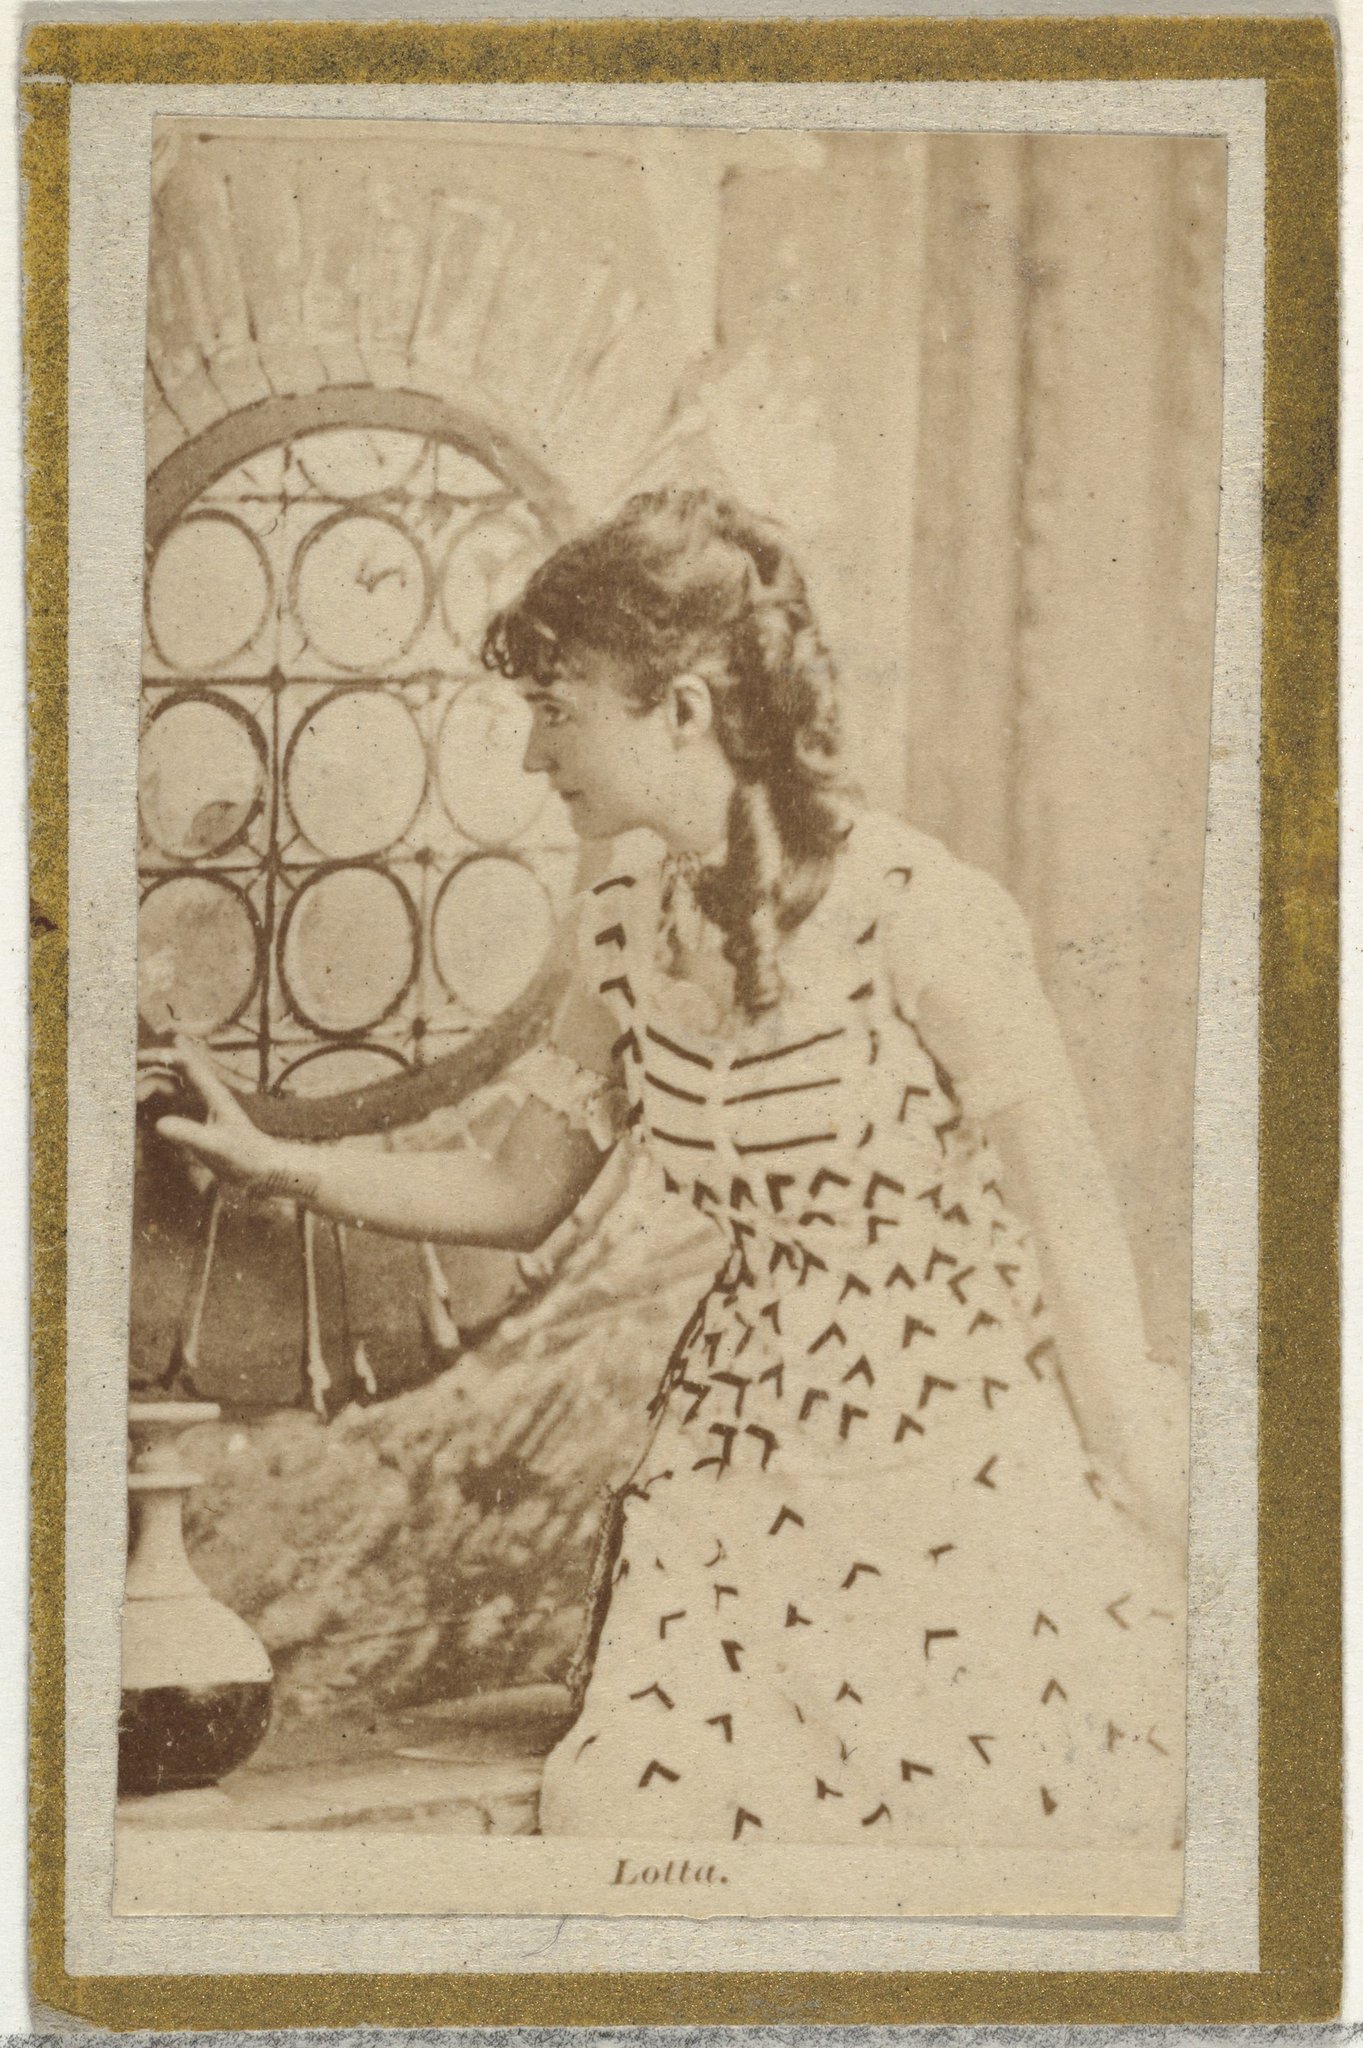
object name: photograph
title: Lotta, from the Actresses and Celebrities series (N60, Type 2) promoting Little Beauties Cigarettes for Allen & Ginter brand tobacco products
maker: allen & ginter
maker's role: publisher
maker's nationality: american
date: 1887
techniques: albumen silver print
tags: portraits,profiles,women,actresses